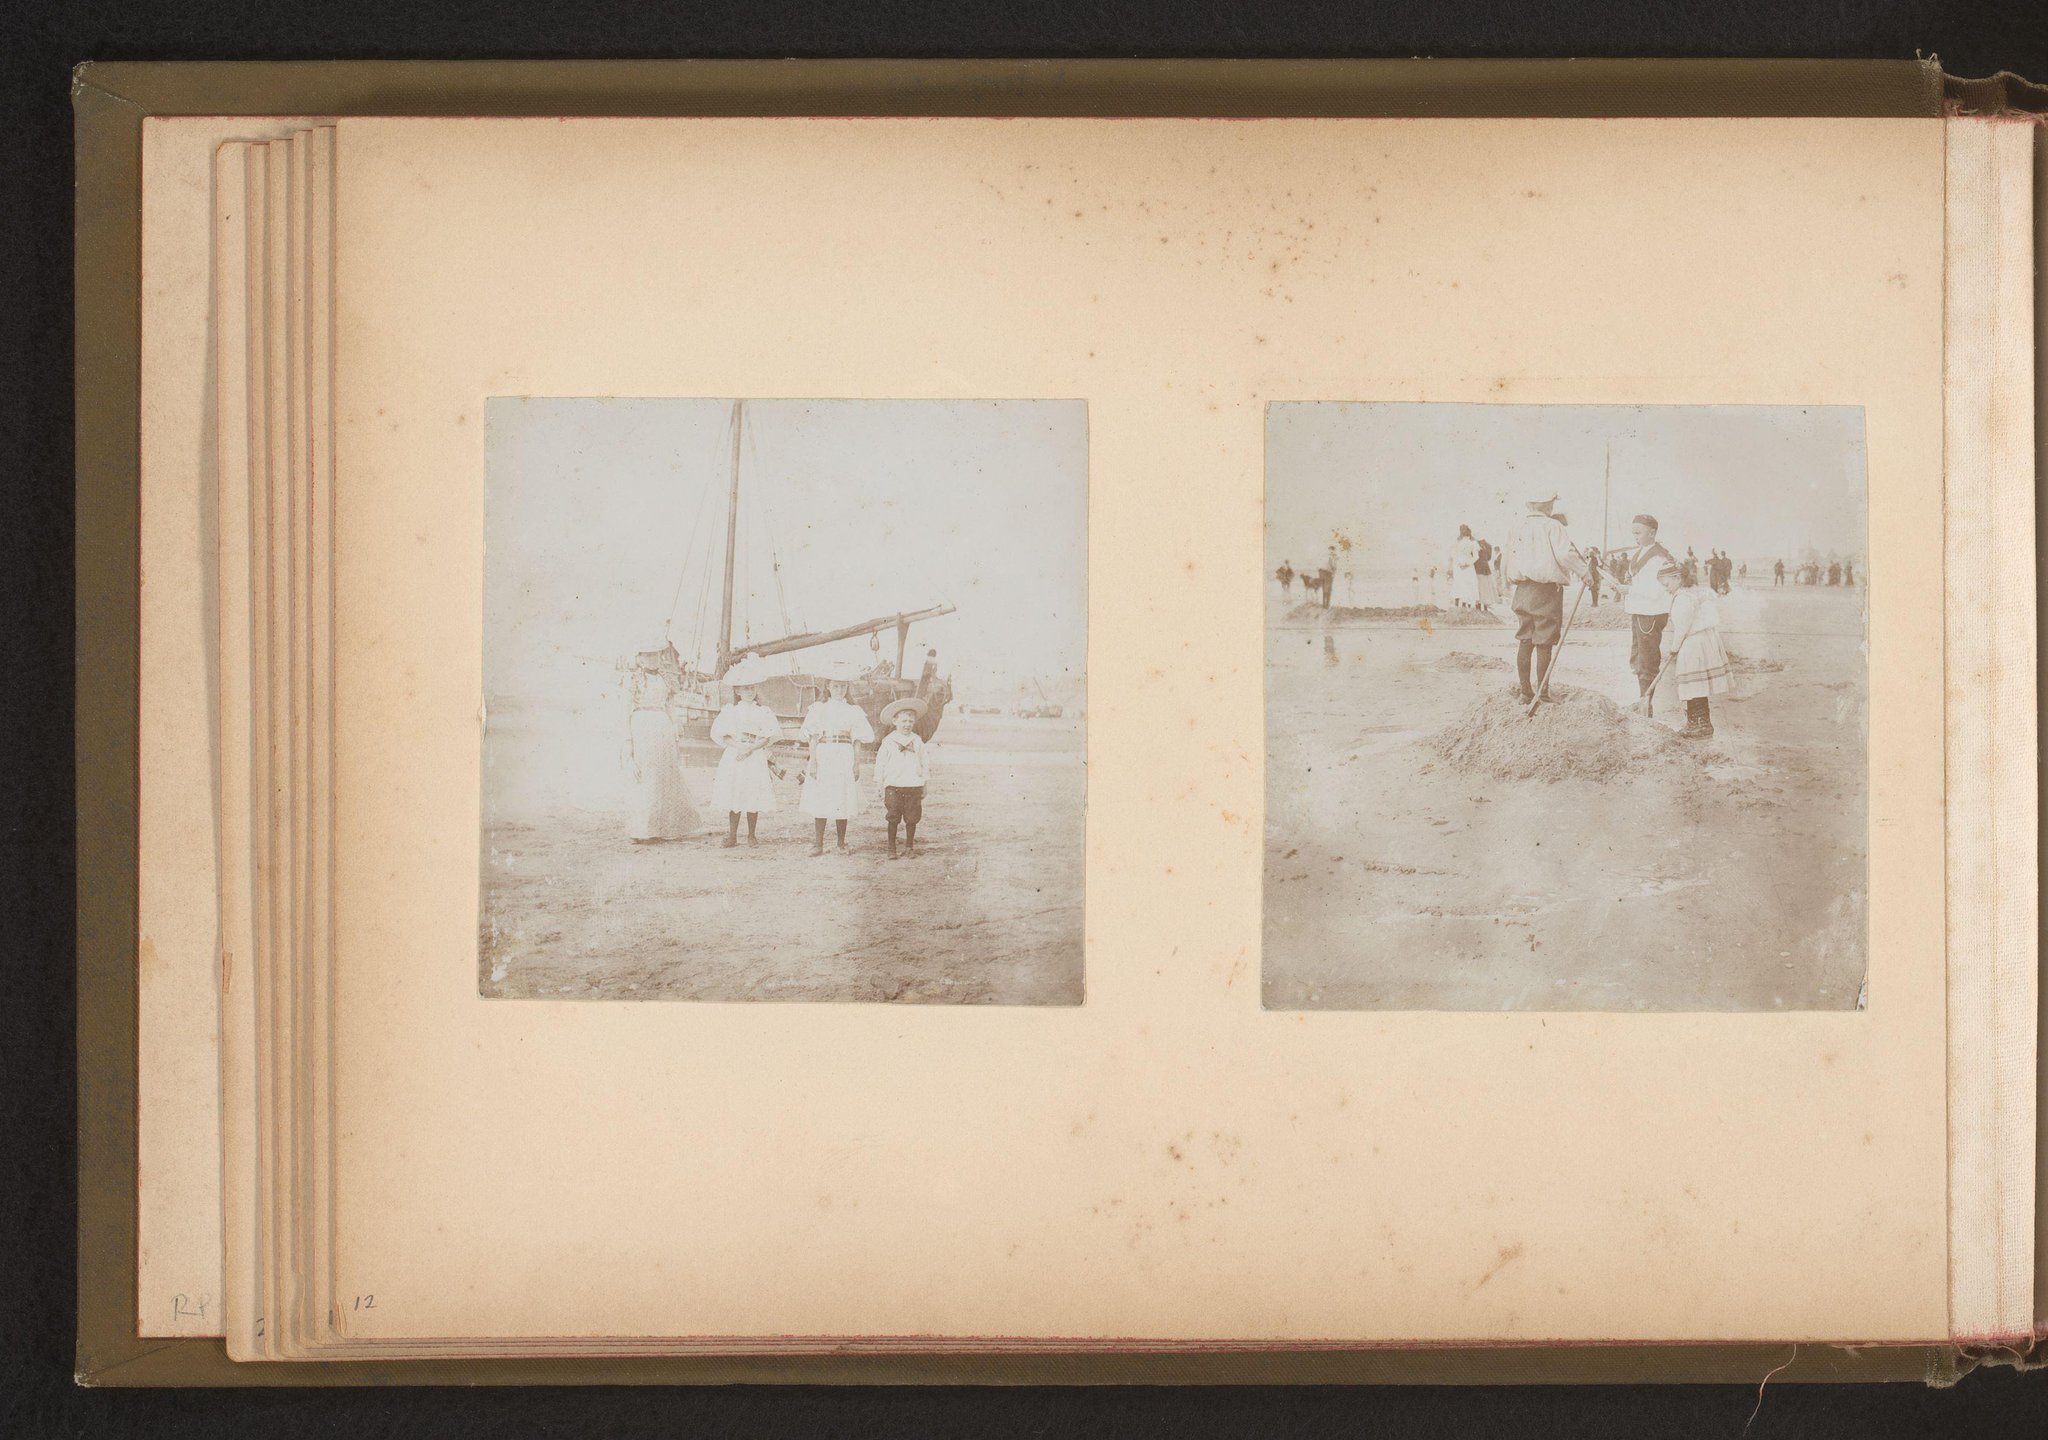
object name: photograph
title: Twee foto's van een vrouw en kinderen op het strand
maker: Anonymous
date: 1895-1910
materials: paper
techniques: collodion silver print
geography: zandvoort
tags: beach (as place of recreation), adult woman, child and nature (games and plays)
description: Deze foto's maken deel uit van een album.